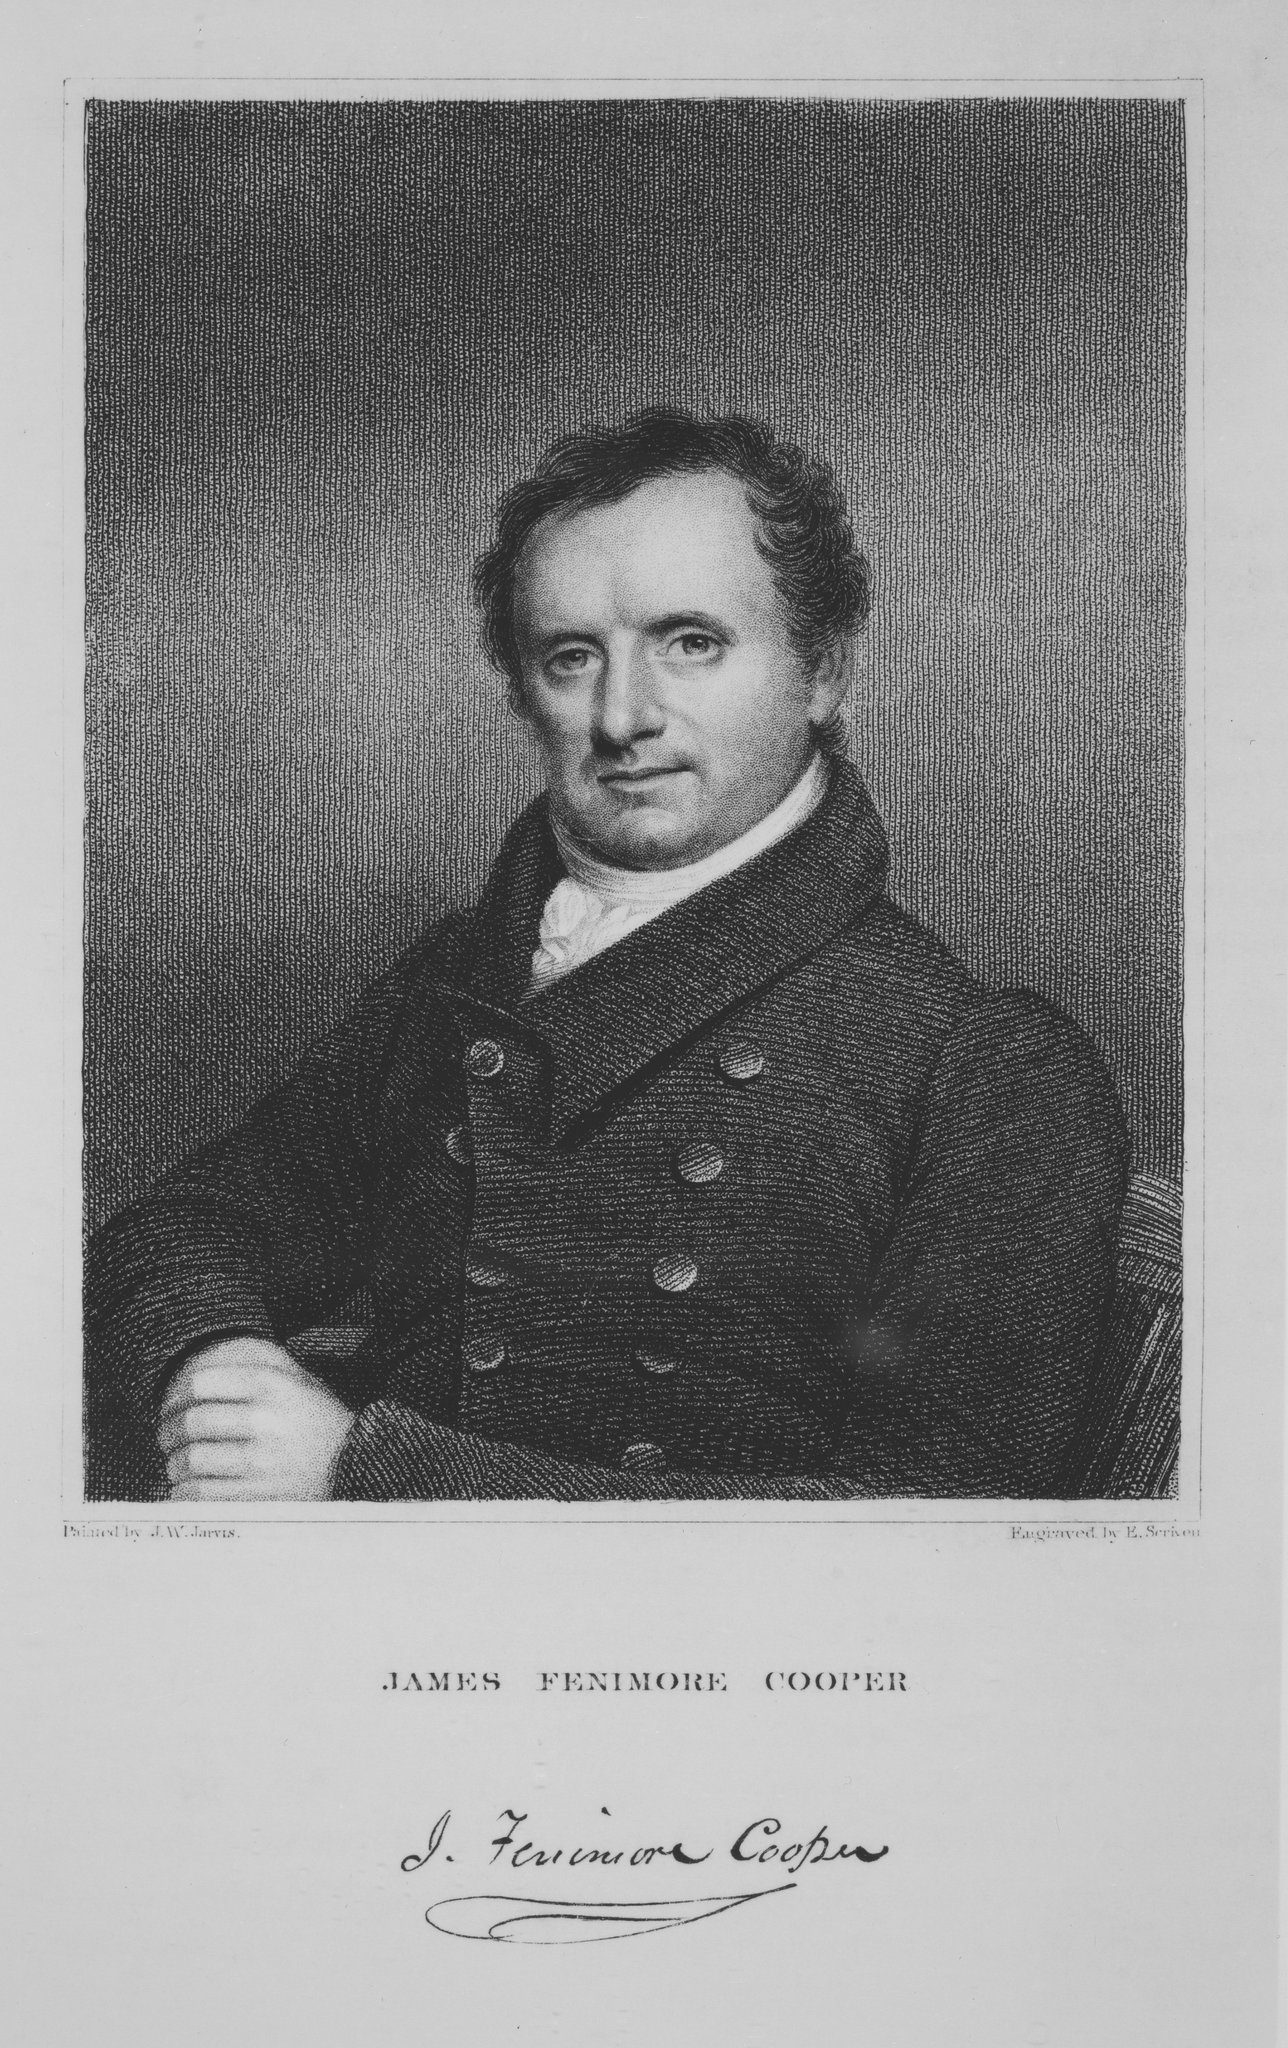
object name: book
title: The National Portrait Gallery of Distinguished Americans, Vol. I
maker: james herring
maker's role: editor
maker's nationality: american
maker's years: 1794-1867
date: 1834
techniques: etching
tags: men,portraits